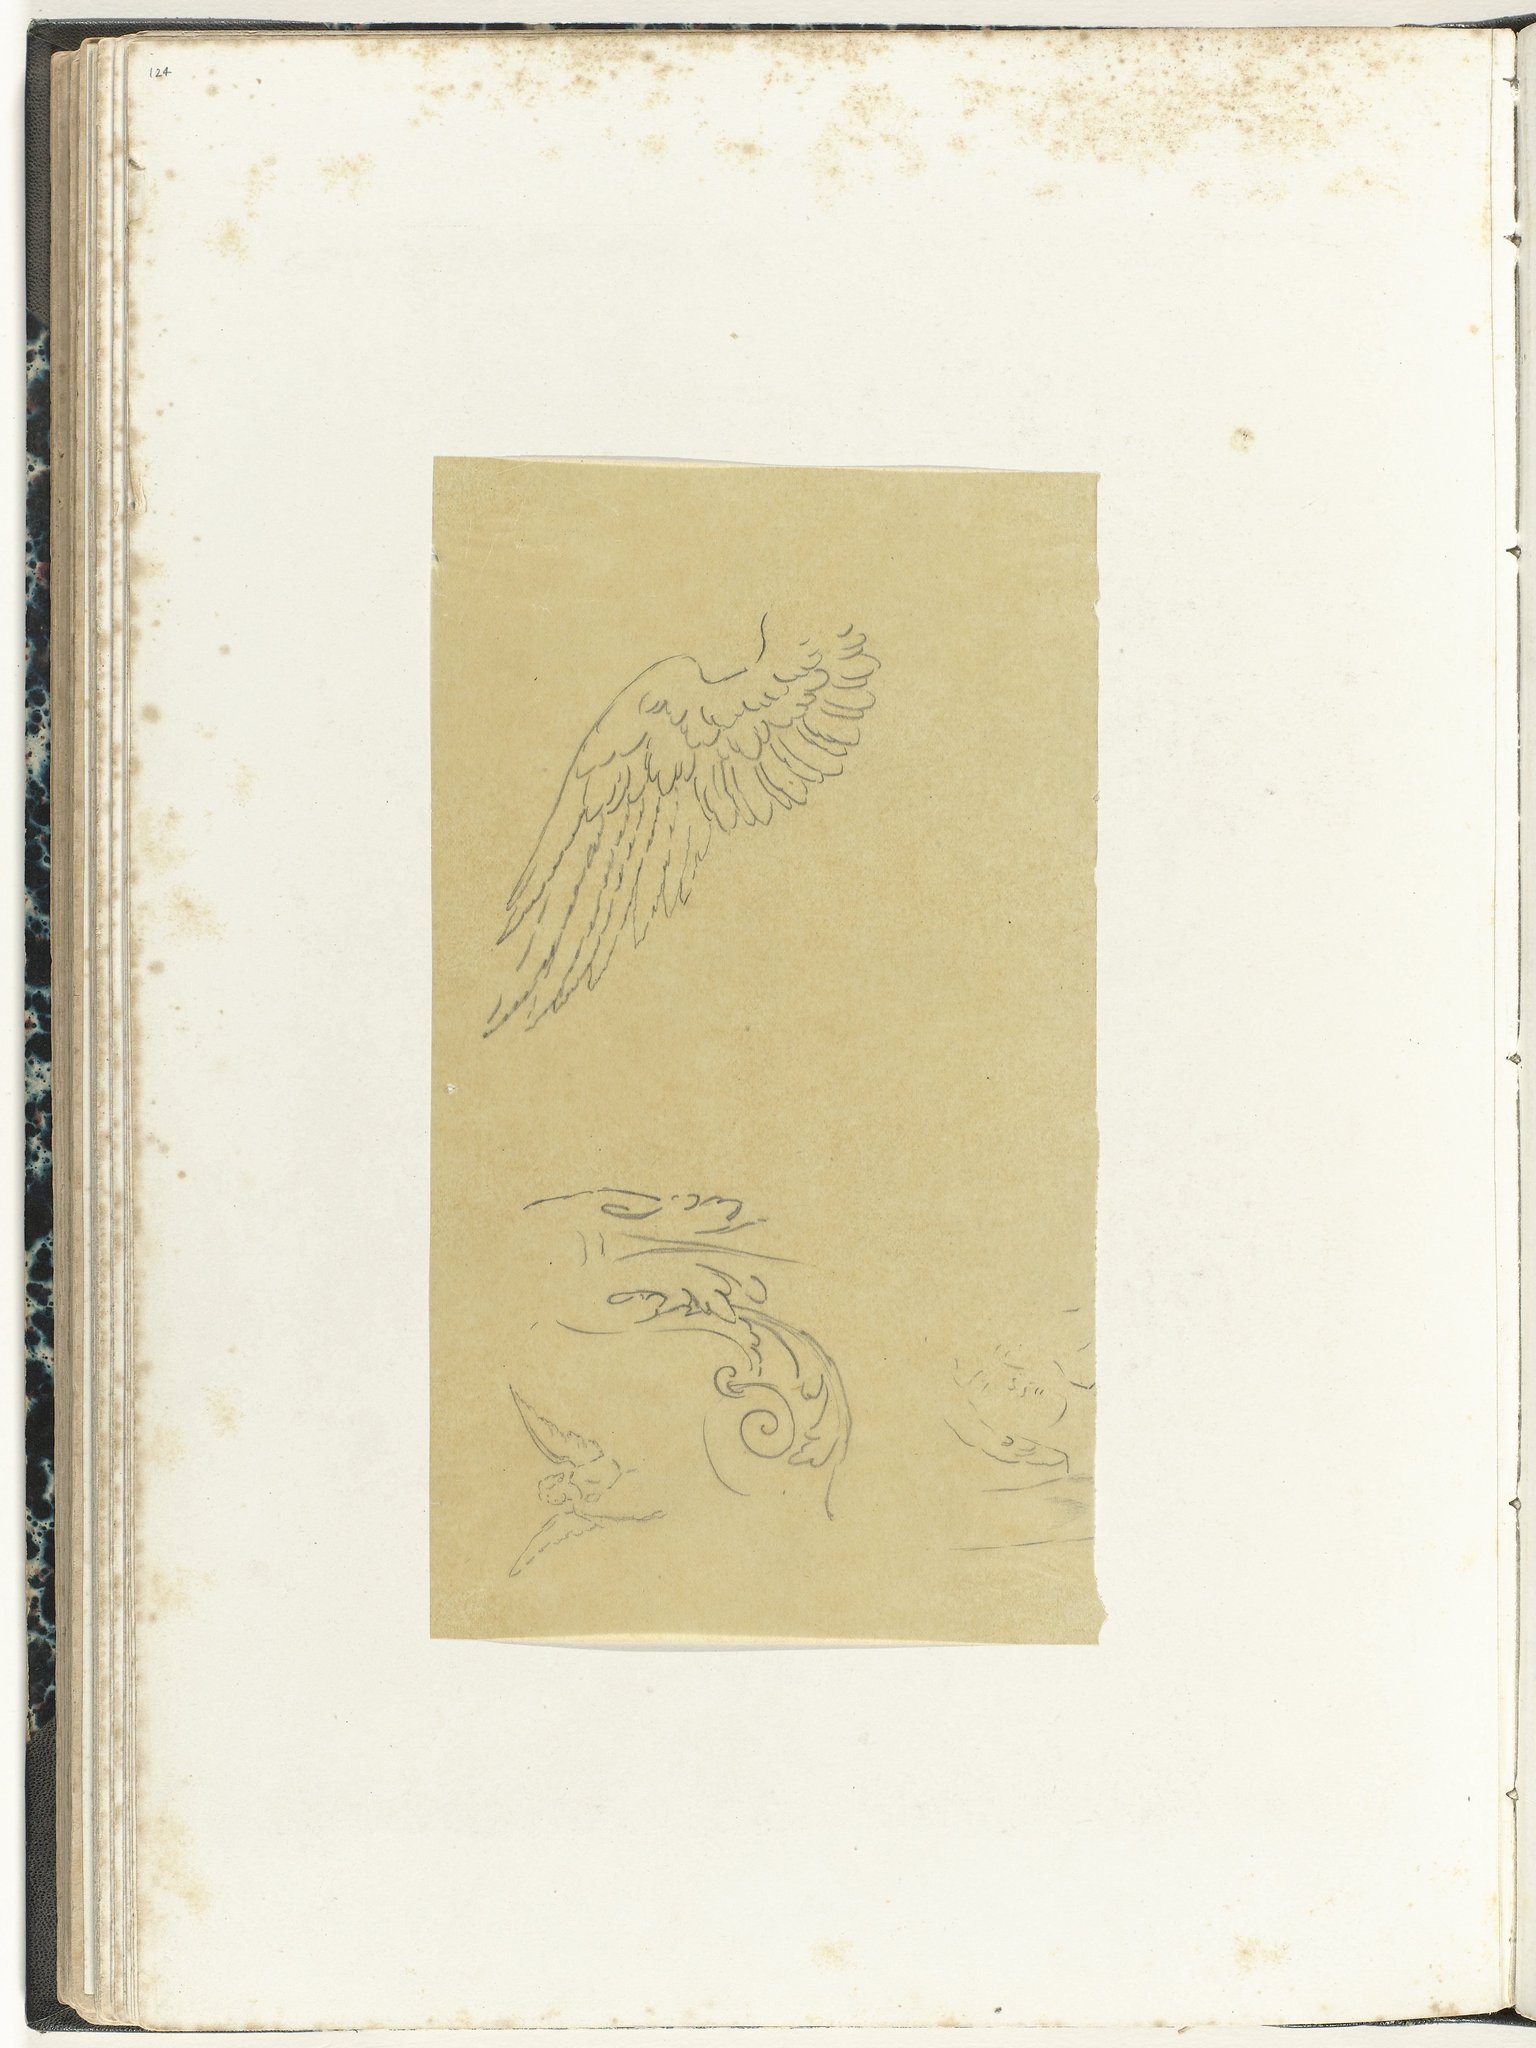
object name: drawing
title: Gevleugelde figuur met details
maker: Anonymous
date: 1866-1900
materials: pencil, paper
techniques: drawing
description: Linksonder staat het bovenlichaam van een gevleugelde figuur afgebeeld, bovenaan op het blad een vleugel, daaronder een vleugel of onderlichaam uitlopend in een bladrank (?) en rechtsonder een hoofd.